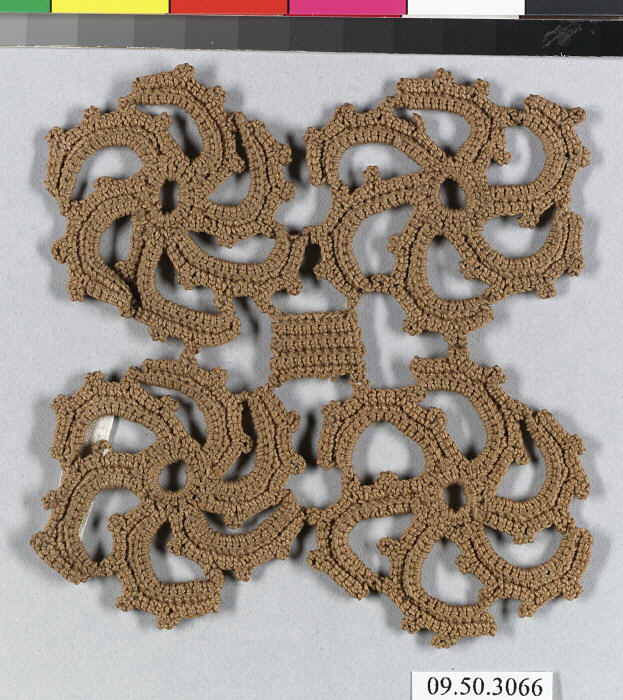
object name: sample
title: Crochet Work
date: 1801-1900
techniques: crochet